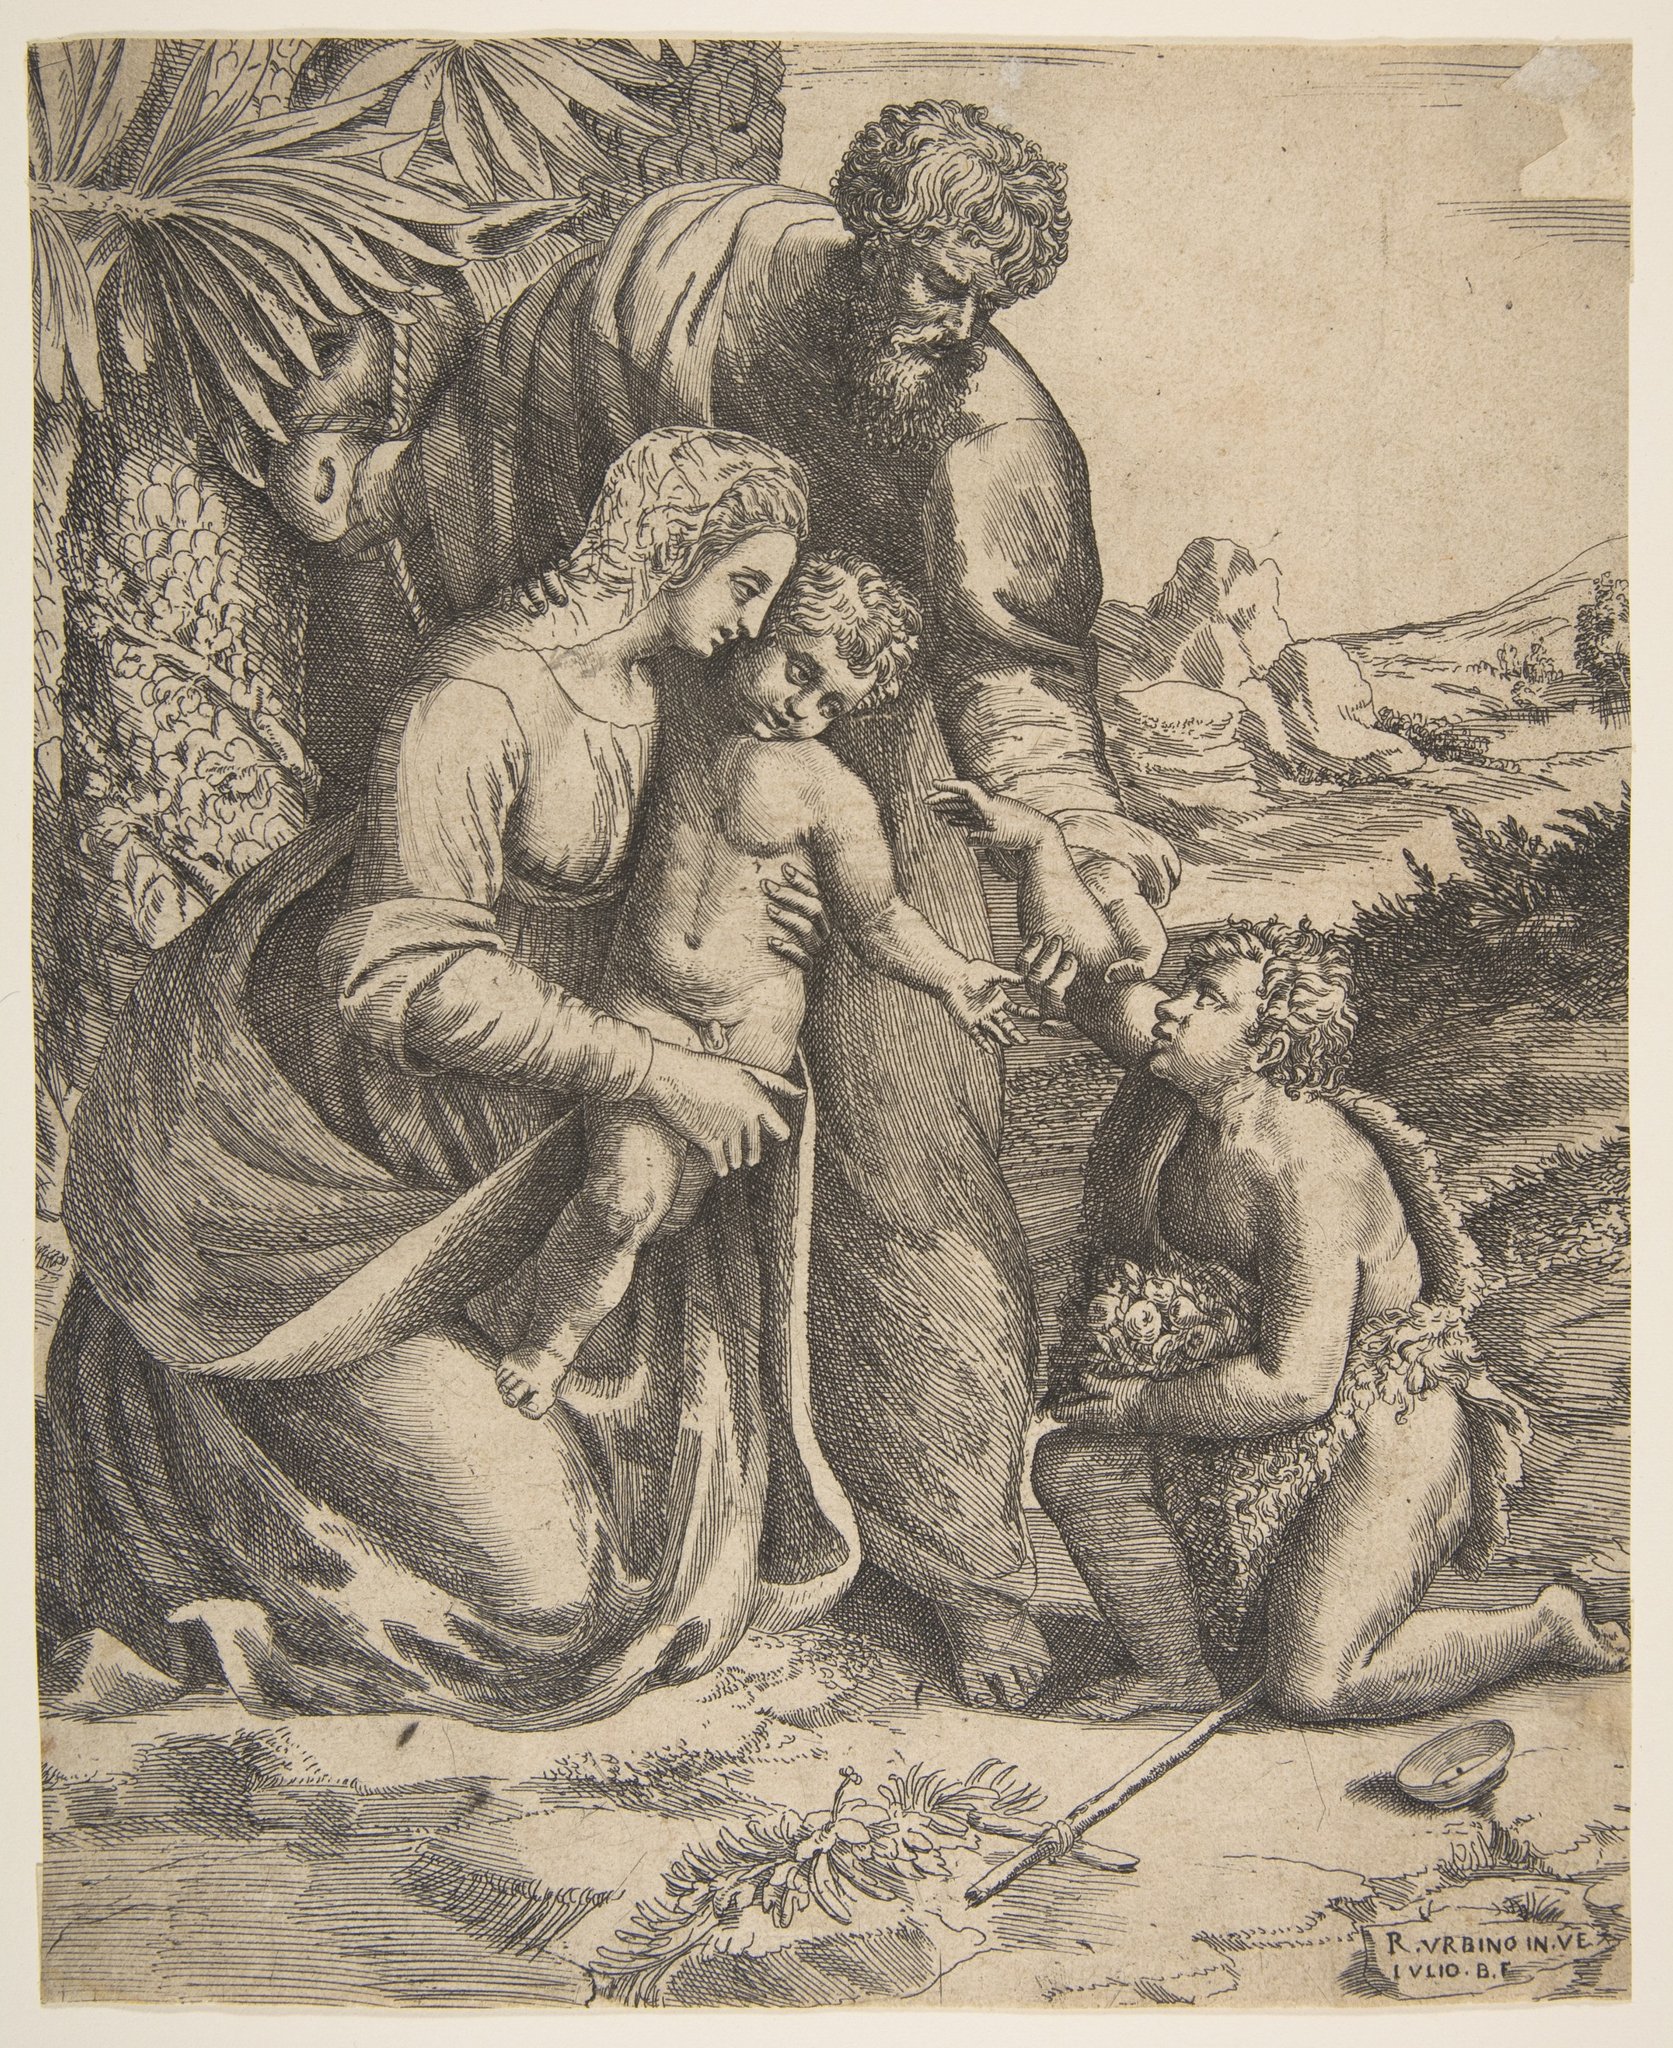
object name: print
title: Holy Family with Saint John the Baptist who kneels at the right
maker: giulio bonasone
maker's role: artist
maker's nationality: italian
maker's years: 1510-1576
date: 1531-1576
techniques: engraving, etching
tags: men,holy family,madonna and child,saint john the baptist